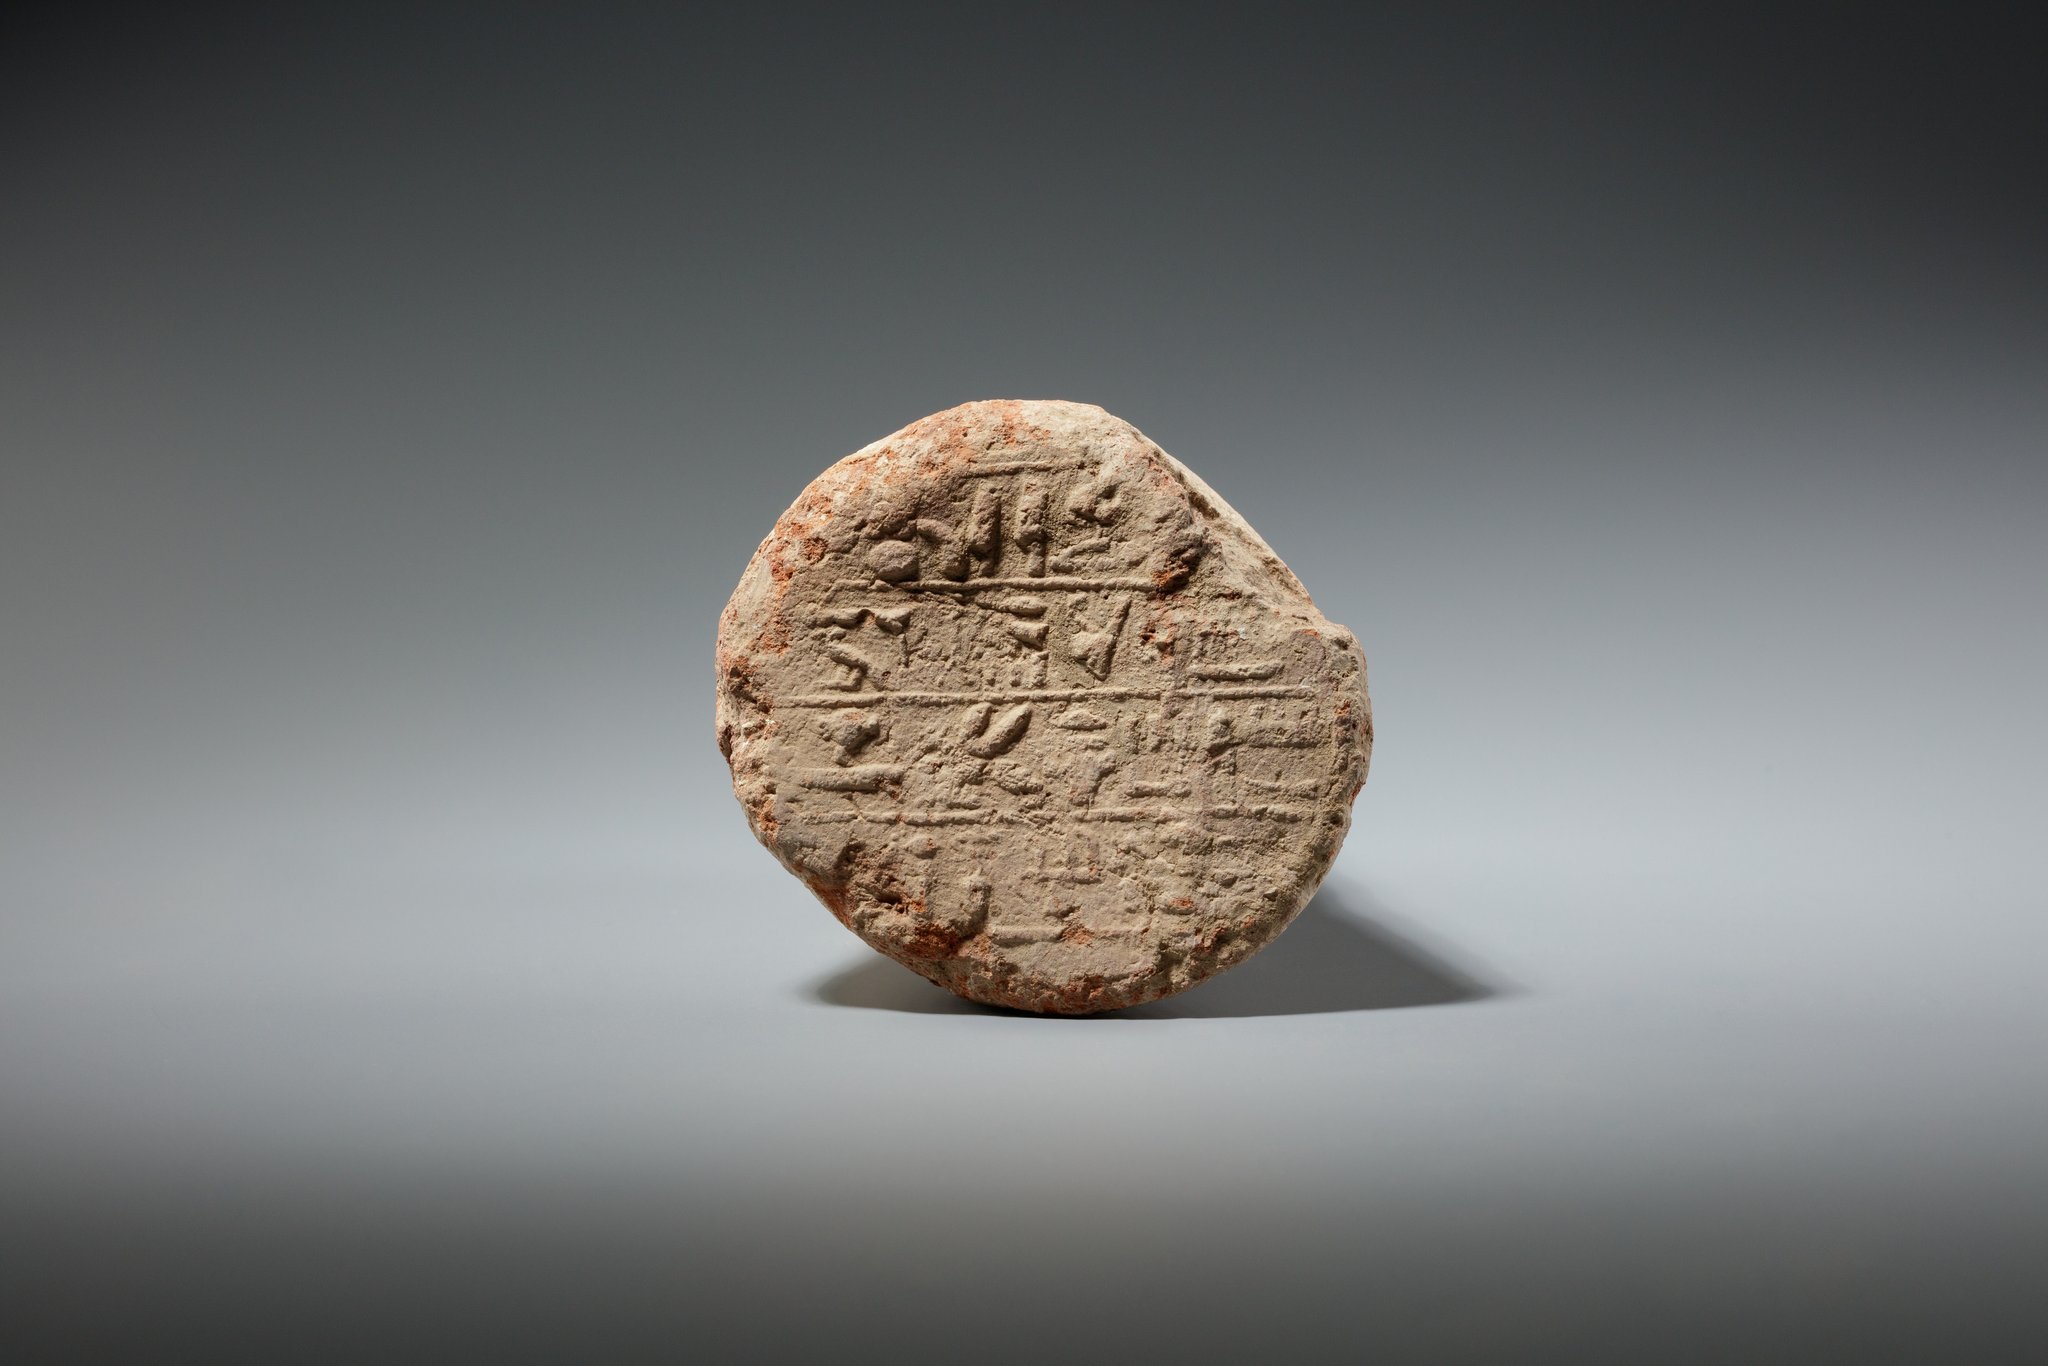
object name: cone, davy 405, neferkhawet, wab priest, bee keeper, amun, field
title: Funerary Cone of the Wab-Priest Neferkhawet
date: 1550-1295 BCE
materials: pottery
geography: egypt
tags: hieroglyphs